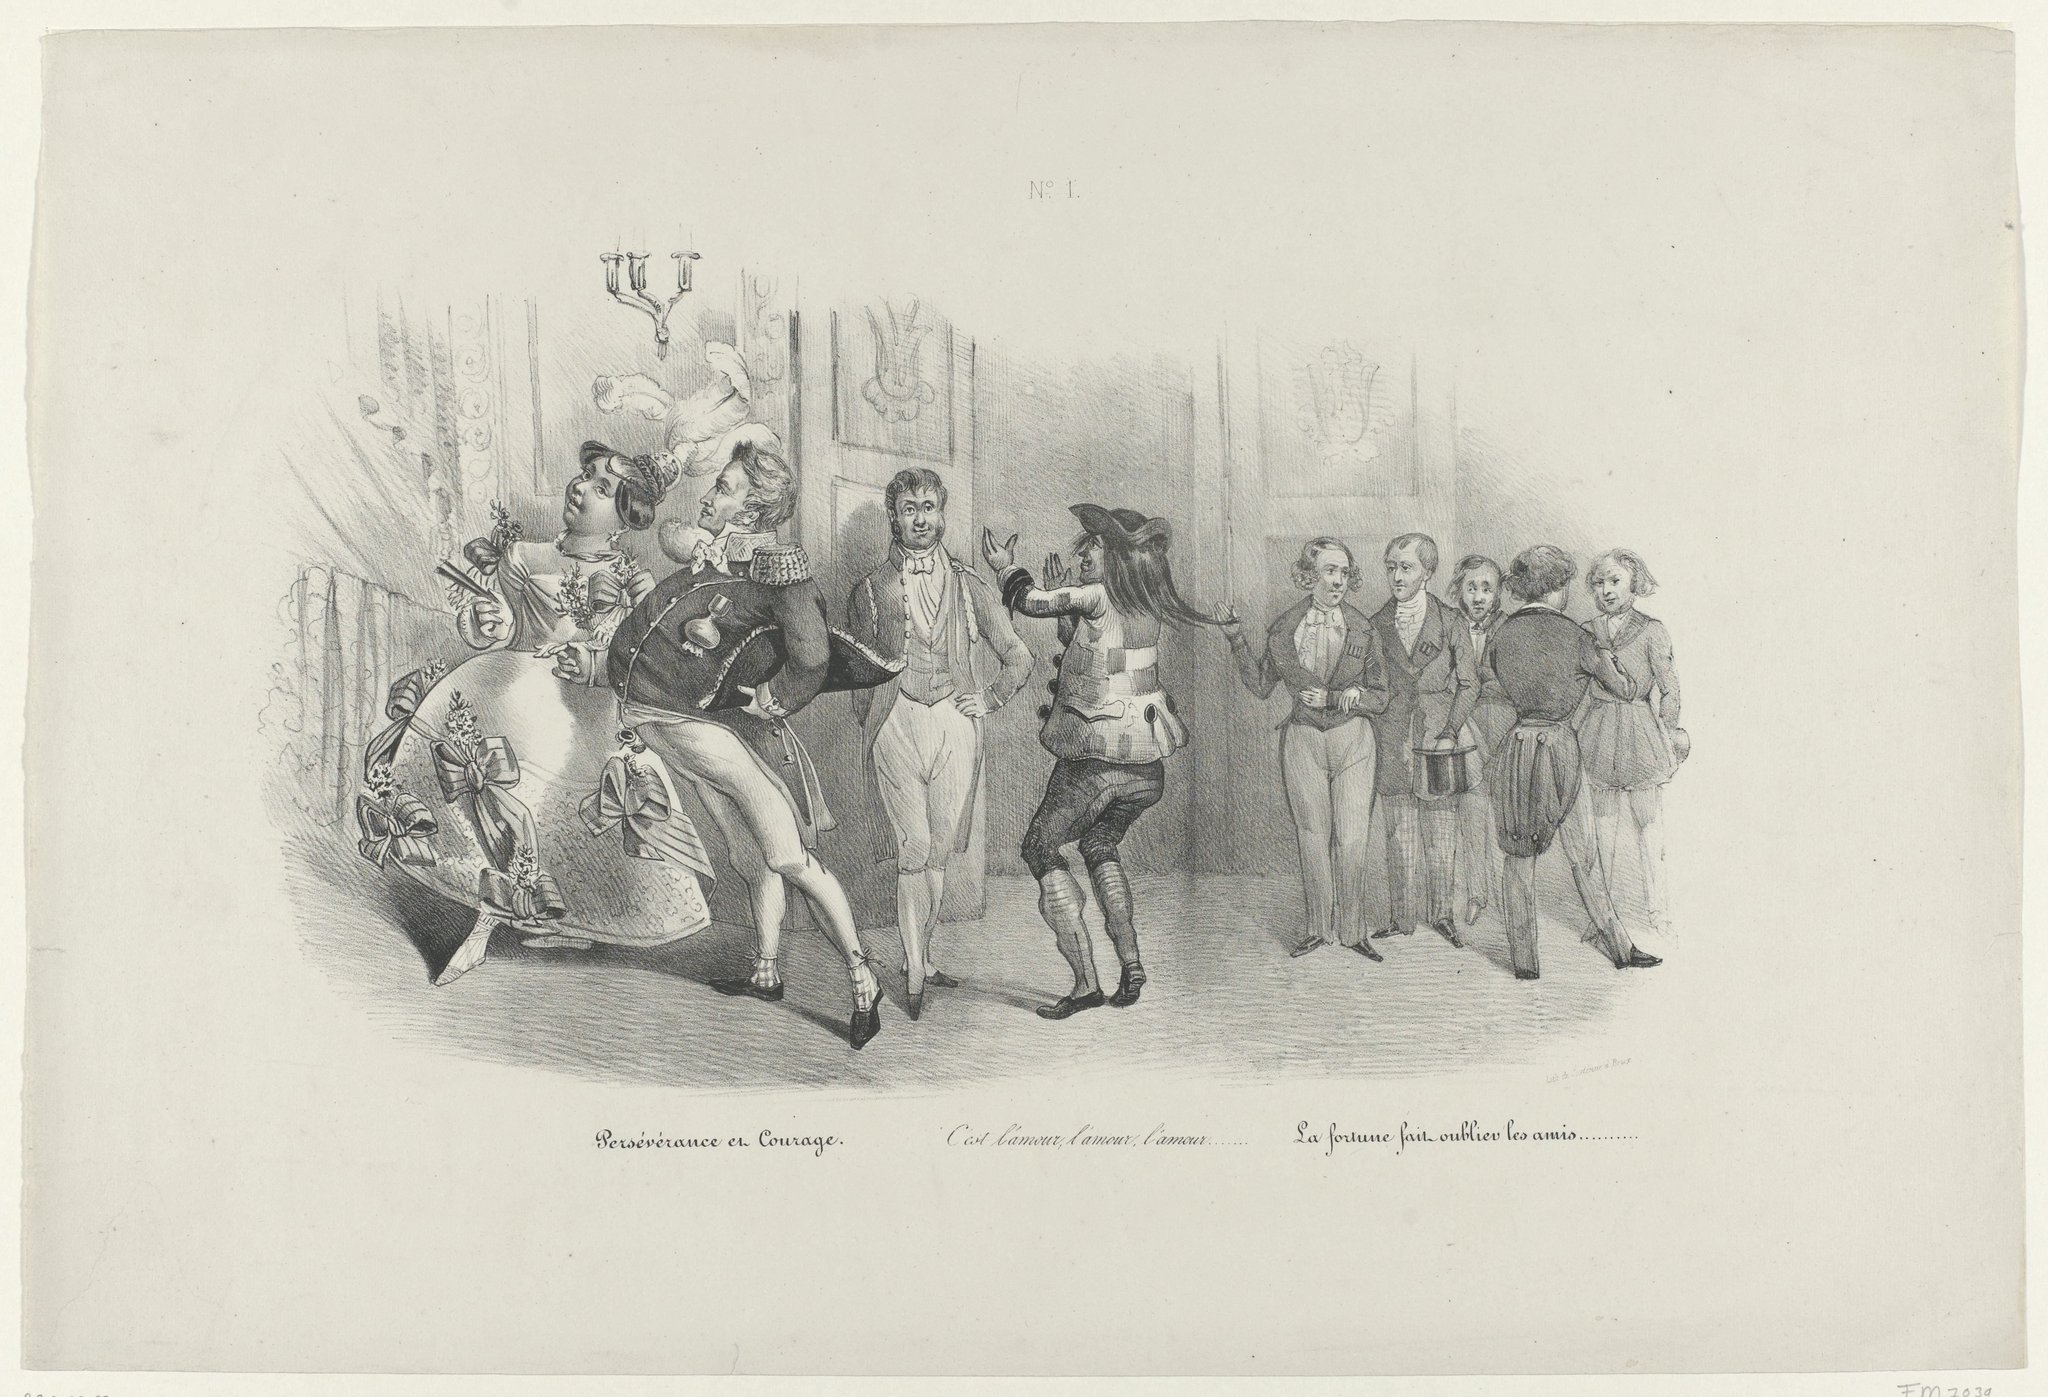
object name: cartoon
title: Spotprent op het huwelijk van voormalige koning Willem I met de gravin d'Oultremont, 1841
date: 1841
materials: paper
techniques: lithograph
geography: brussels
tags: the hague, berlin, william i of the netherlands, one pair dancing; man and woman dancing as a couple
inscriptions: collector's mark: Lugt 2166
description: Spotprent op het huwelijk van voormalige koning Willem I met Henriëtte d'Oultremont in Berlijn op 17 februari 1841. Willem dansend met Henriëtte aan de hand, in het midden een klappende en zingende Savoyaard, rechts kijken vijf heren beteuterd toe. Bovenaan genummerd: No. 1.